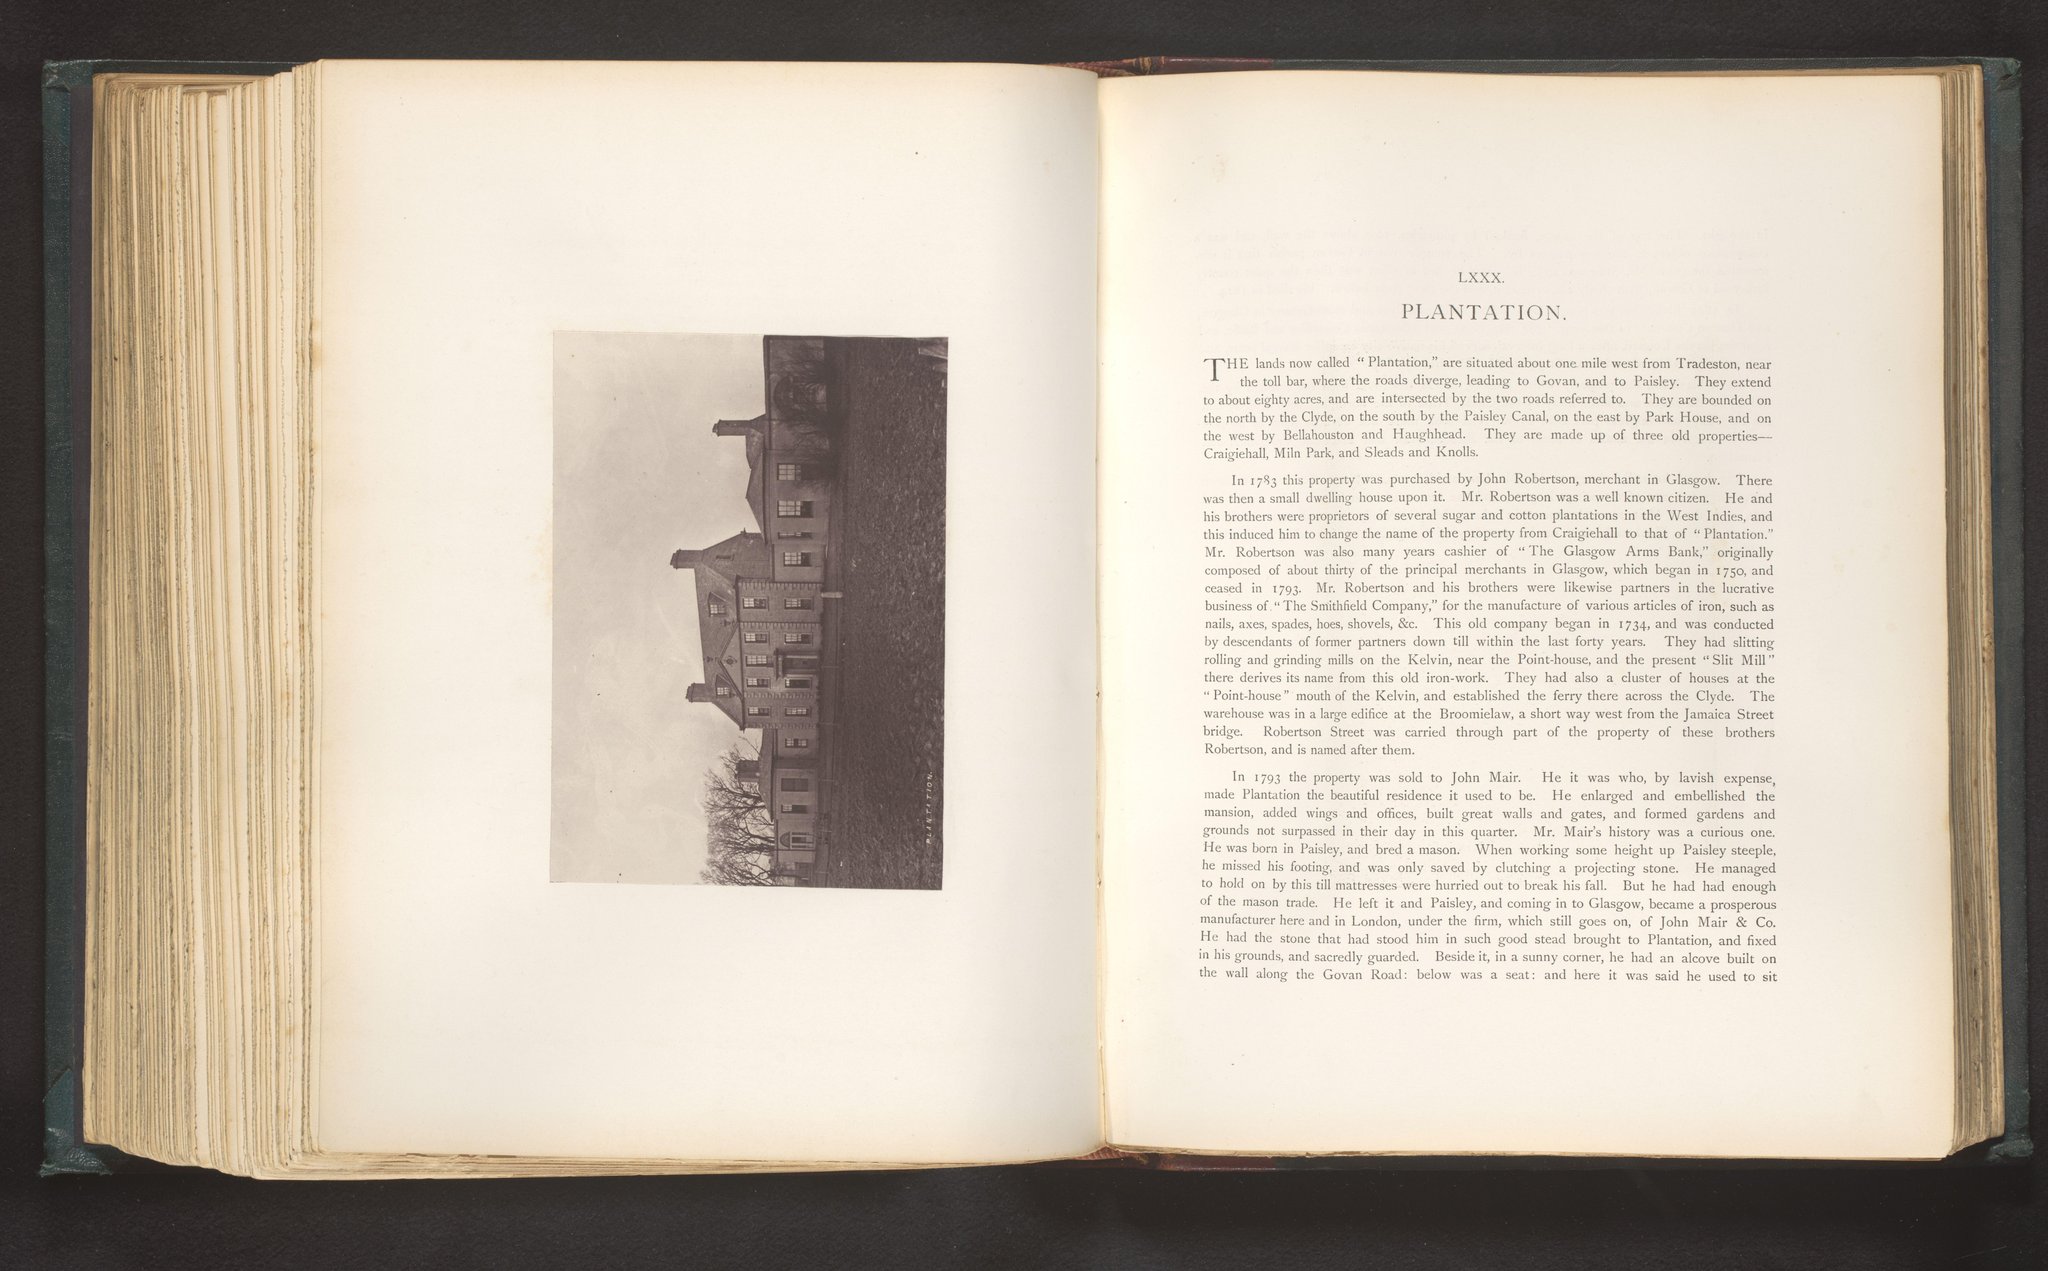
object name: page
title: Plantation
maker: thomas annan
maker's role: fotograaf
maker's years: 1829-1887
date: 1868-1878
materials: paper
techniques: carbon print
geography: glasgow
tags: rural housing, e.g. country-house, villa, cottage, façade (of house or building)